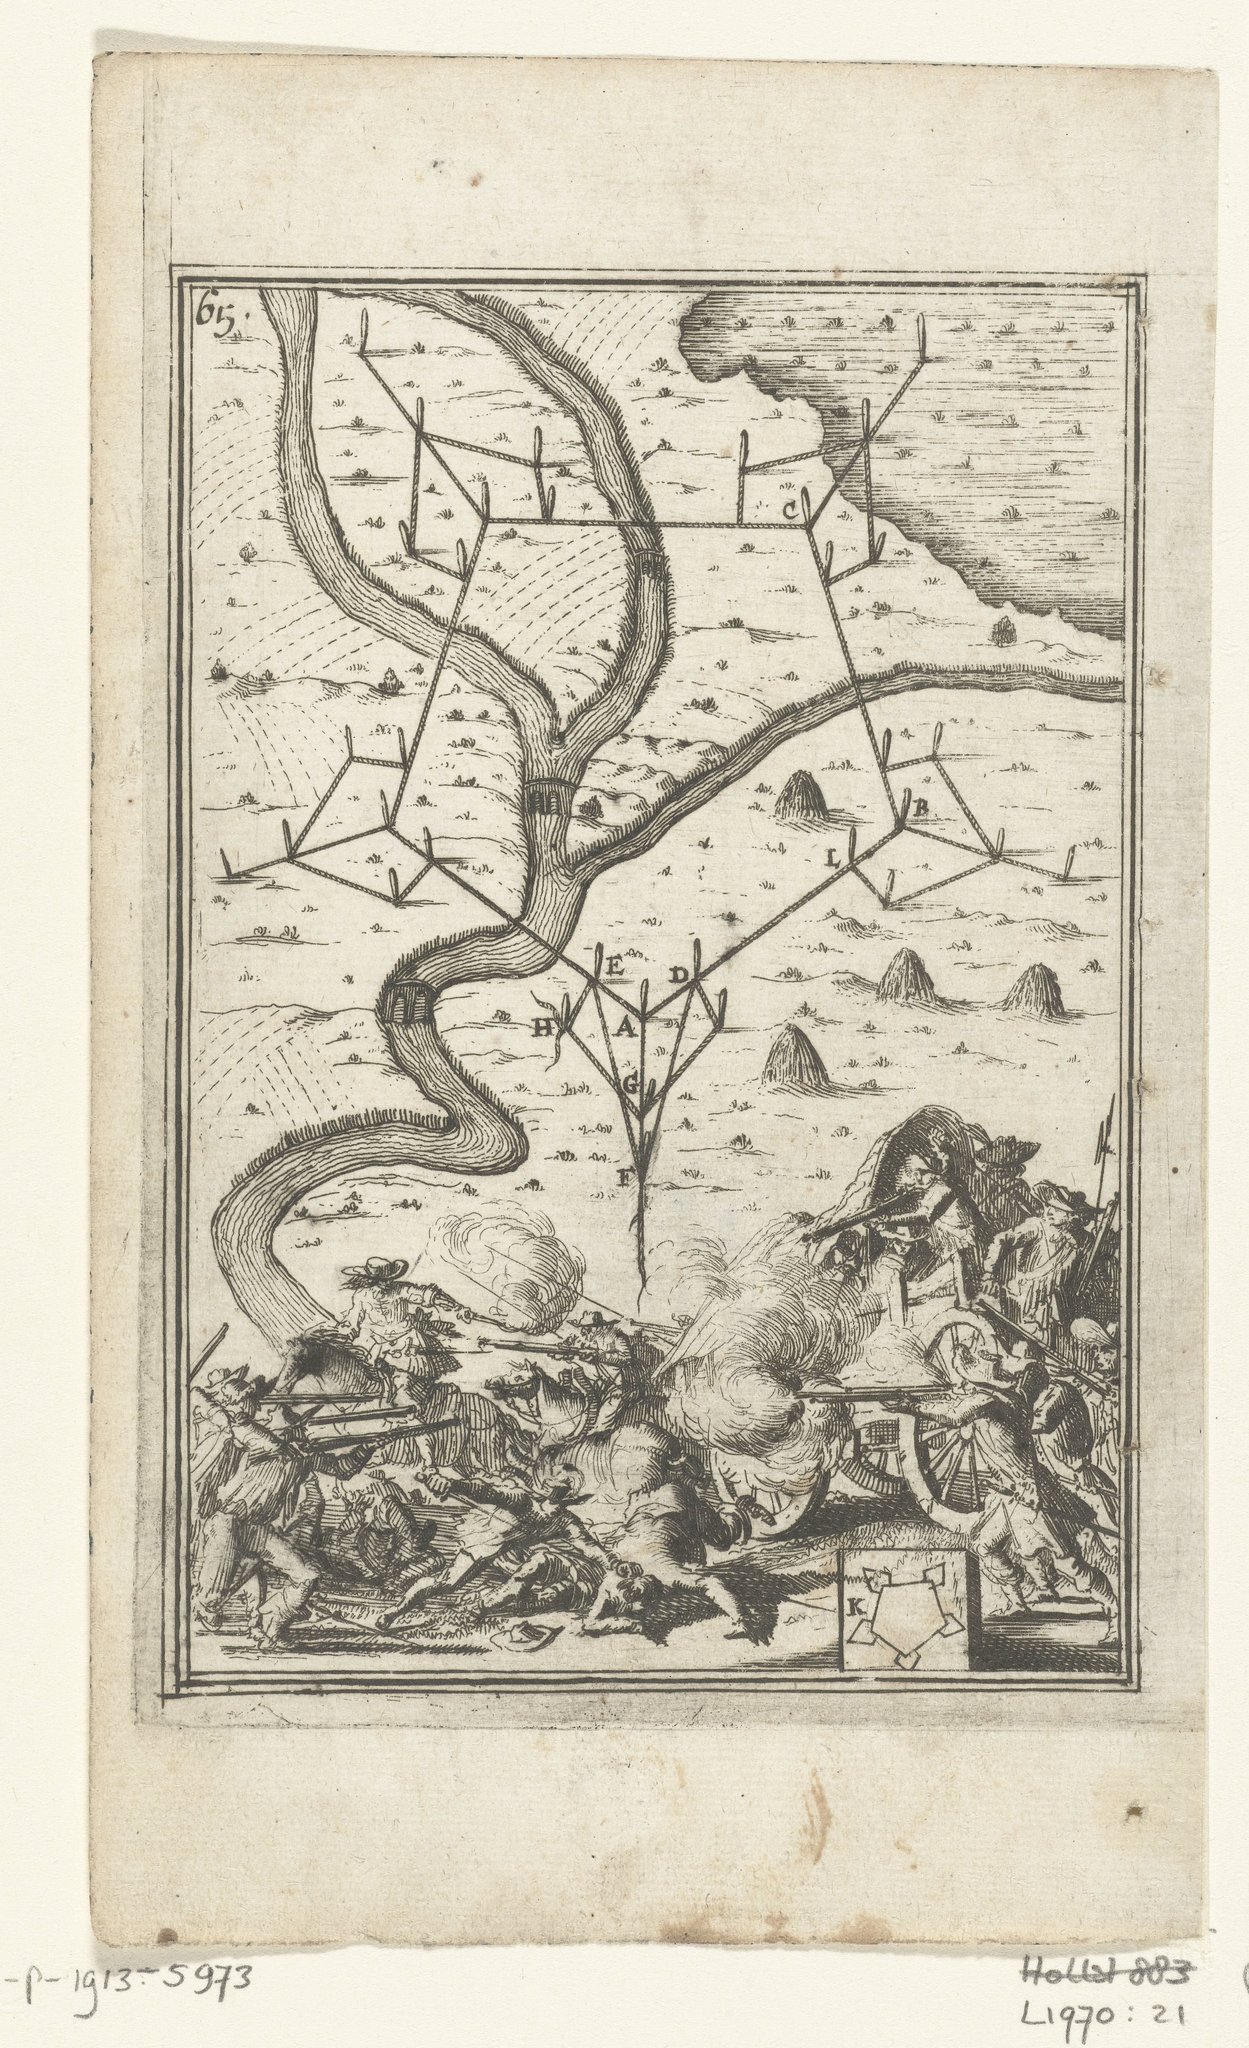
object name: book illustration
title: Illustratie voor 'Den Arbeid van Mars' van Allain Manesson Mallet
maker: romeyn de hooghe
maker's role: draughtsman, goldsmith, painter, print maker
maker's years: 1645-1708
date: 1672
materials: paper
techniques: engraving, etching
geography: amsterdam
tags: landscapes with waters, waterscapes, seascapes (in the temperate zone), battle, landscape with other man-made constructions not mentioned above, e.g.: graveyards, playgrounds, etc., fortifications, military engineering, mathematics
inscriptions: collector's mark: Lugt 2228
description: Plattegrond van een gebied met daarin de omtrekken voor een vesting, fort of versterking (vijfhoek). Daaronder een vuurgevecht tussen soldaten. In de hoek linksboven het cijfer 65 (= het nummer van de pagina in het boek waartegenover de illustratie geplaatst is).